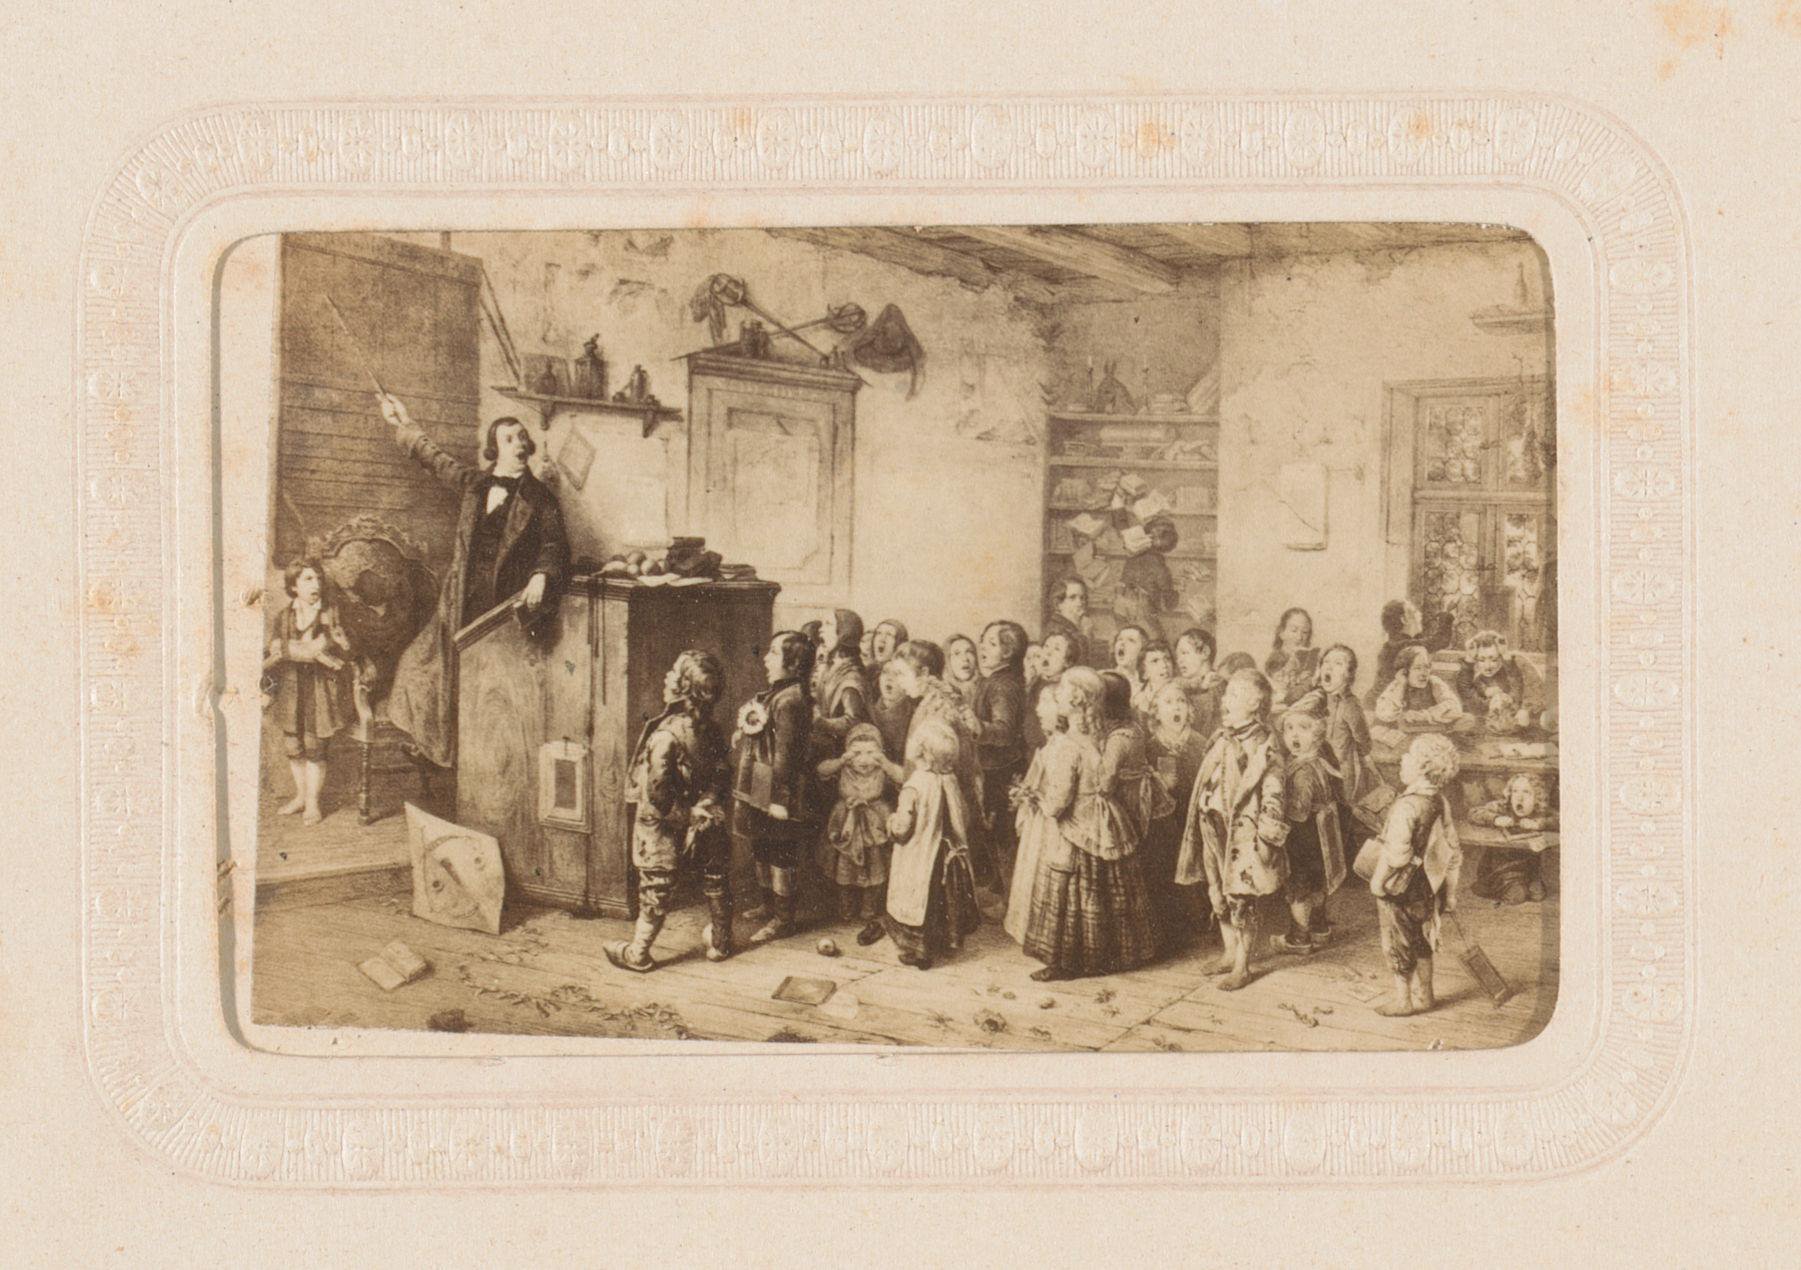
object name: photograph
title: Fotoreproductie van een schilderij met een klaslokaal met zingende kinderen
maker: Anonymous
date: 1855-1865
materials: cardboard, photographic support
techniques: albumen print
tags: children singing